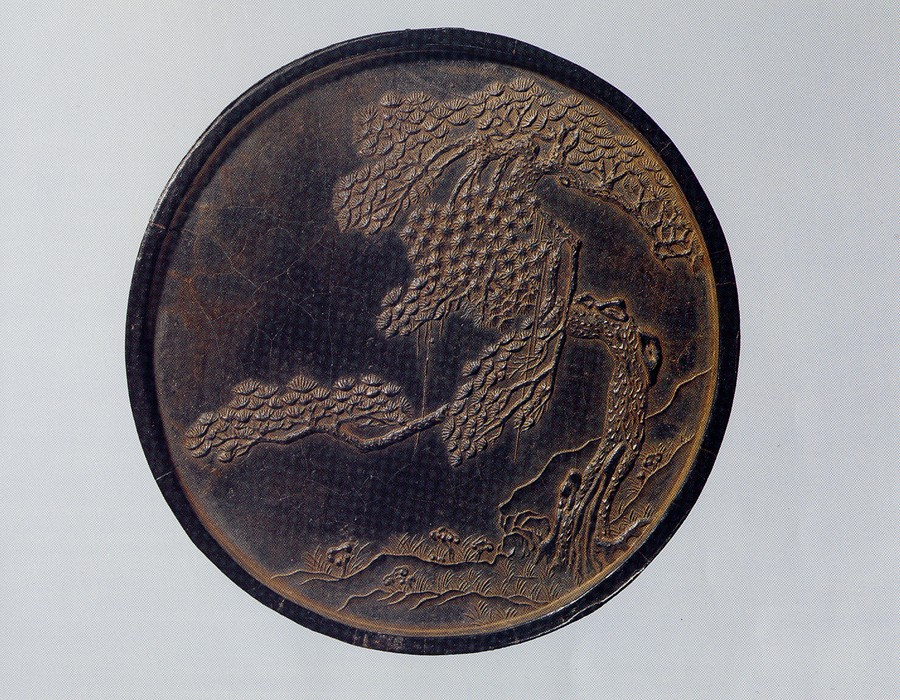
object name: ink tablet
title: Ink Tablet with Thousand-Year Fungus Motif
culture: chinese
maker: cheng junfang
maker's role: artist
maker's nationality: chinese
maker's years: 1541-1620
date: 1867-1933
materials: wood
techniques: bookbinding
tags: trees